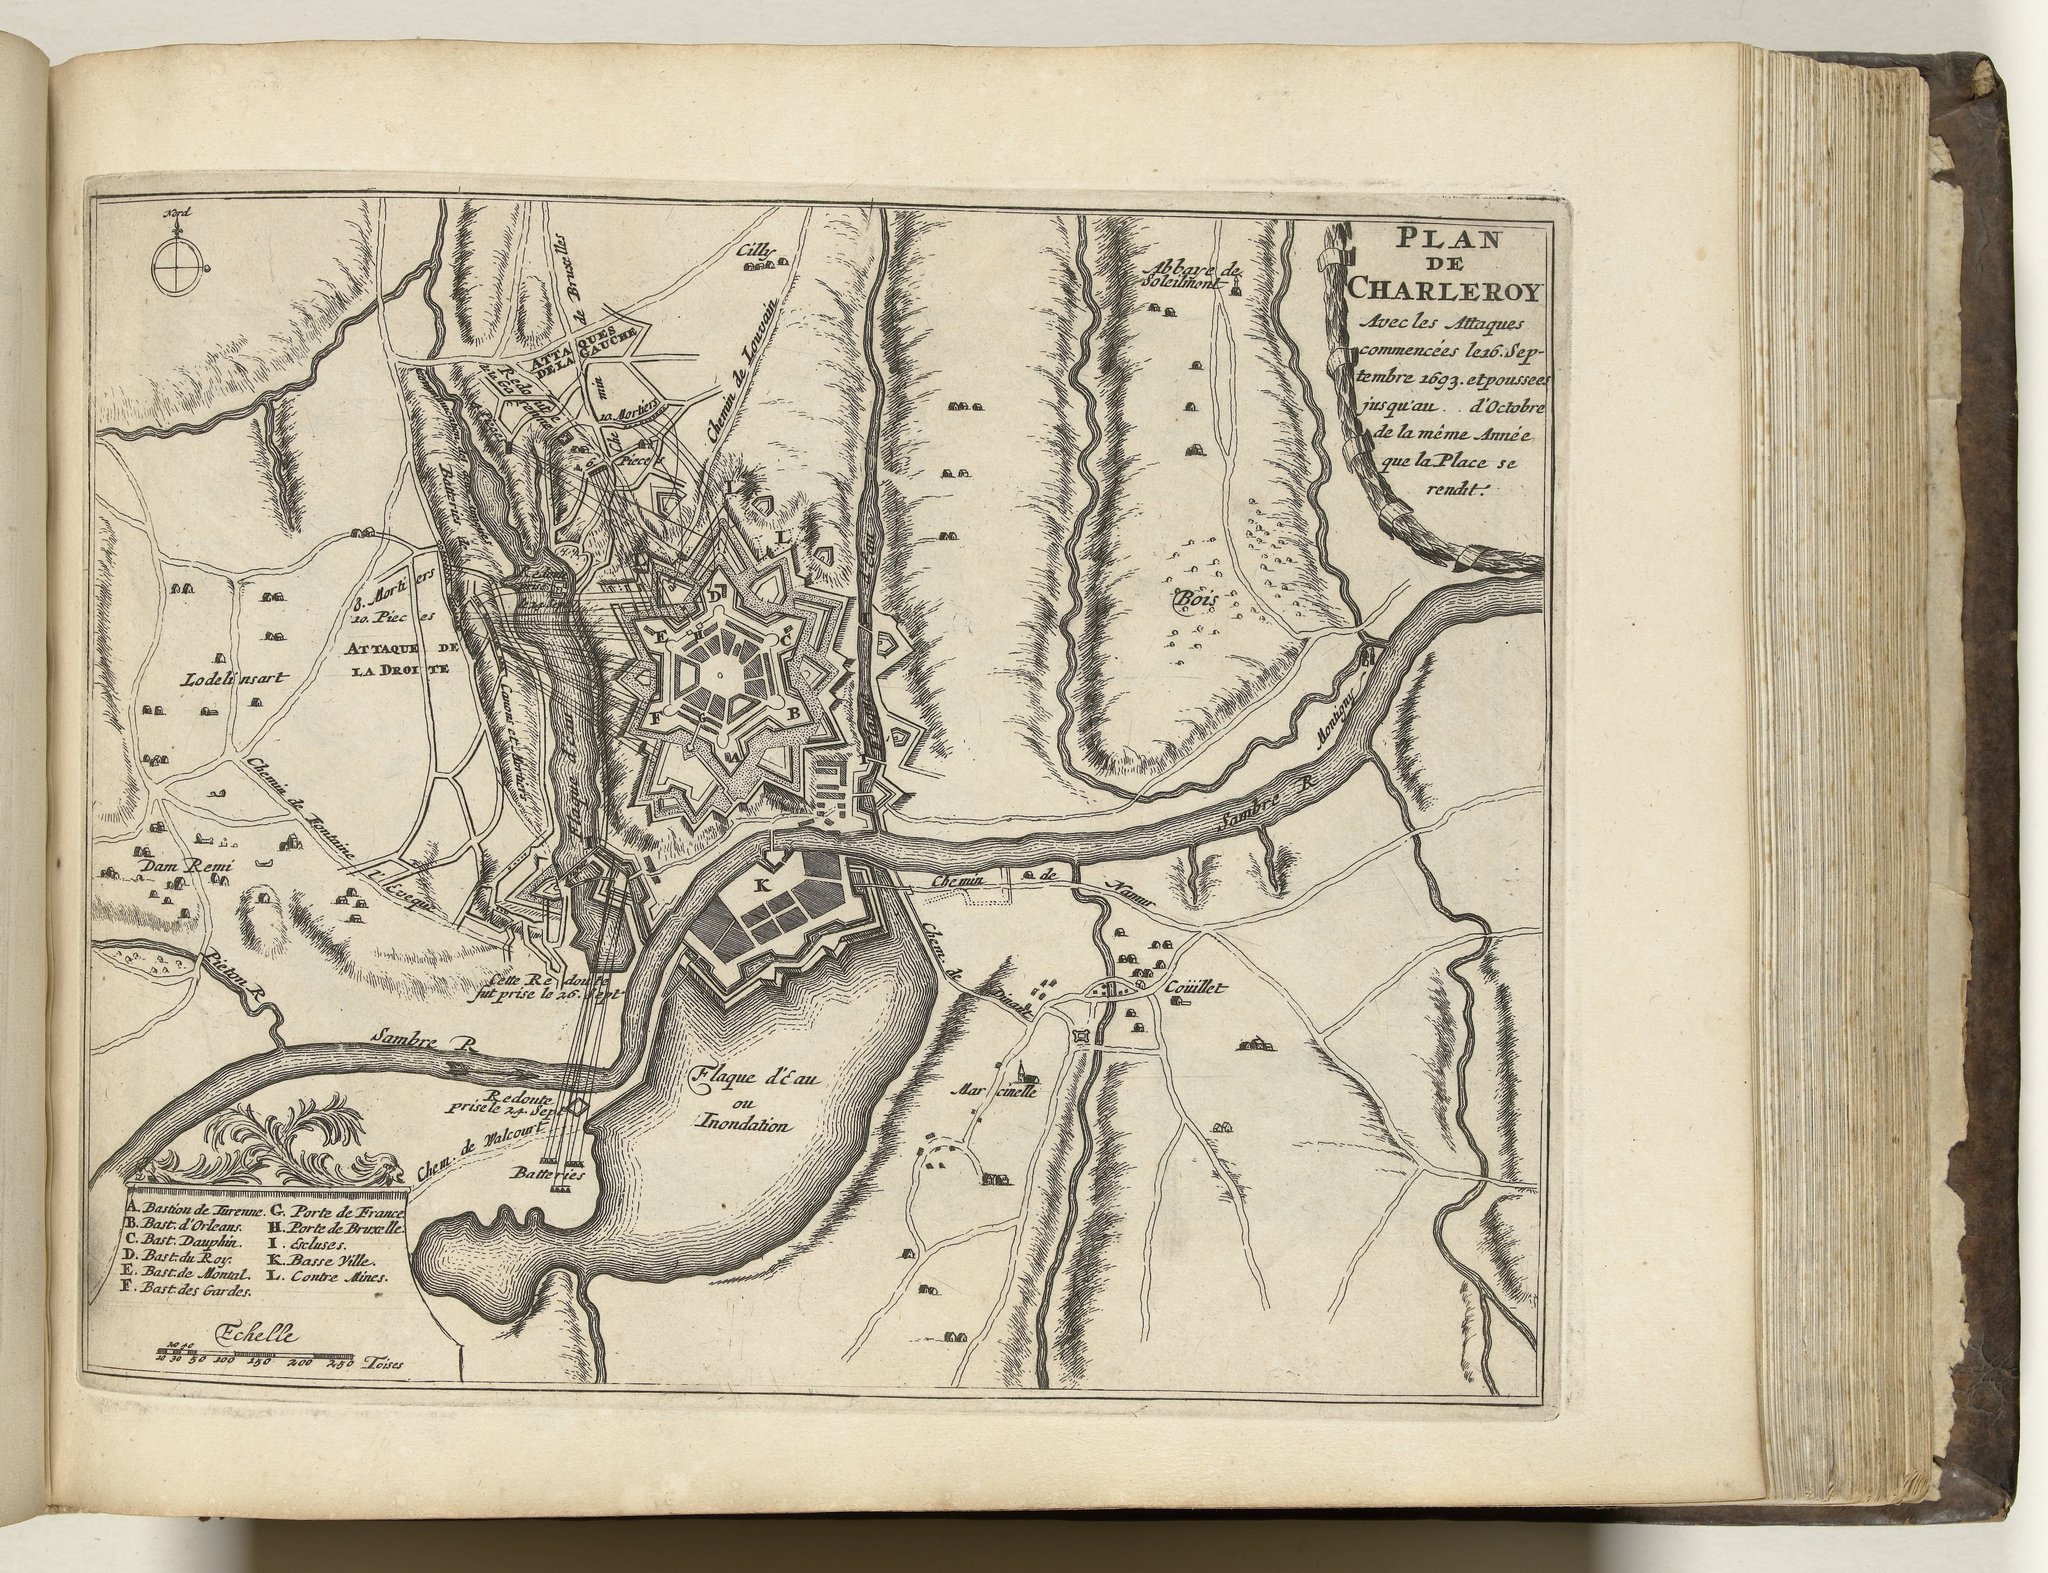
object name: print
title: Plan de Charleroy Avec les Attaques commencées le 16. Septembre 1693 et poussees jus qu'au (...) d'Octobre de la même Année que la Place se rendit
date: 1693-1696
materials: paper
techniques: etching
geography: france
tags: siege, position war, maps of cities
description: Plattegrond met beleg en inname van Charleroi door het Franse leger, september-oktober 1693. Onderdeel van het vijfde deel (1696) van het prentwerk waarin gebundeld zijn de acht delen van Les forces de l'Europe uitgegeven tussen 1693-1697. Het prentwerk bestaat uit 175 platen met plannen (afkomstig van Sébastien Le Prestre, Seigneur de Vauban) van vermaarde sterke steden en vestingen in de Negenjarige Oorlog. Titel en opschriften in het Frans.